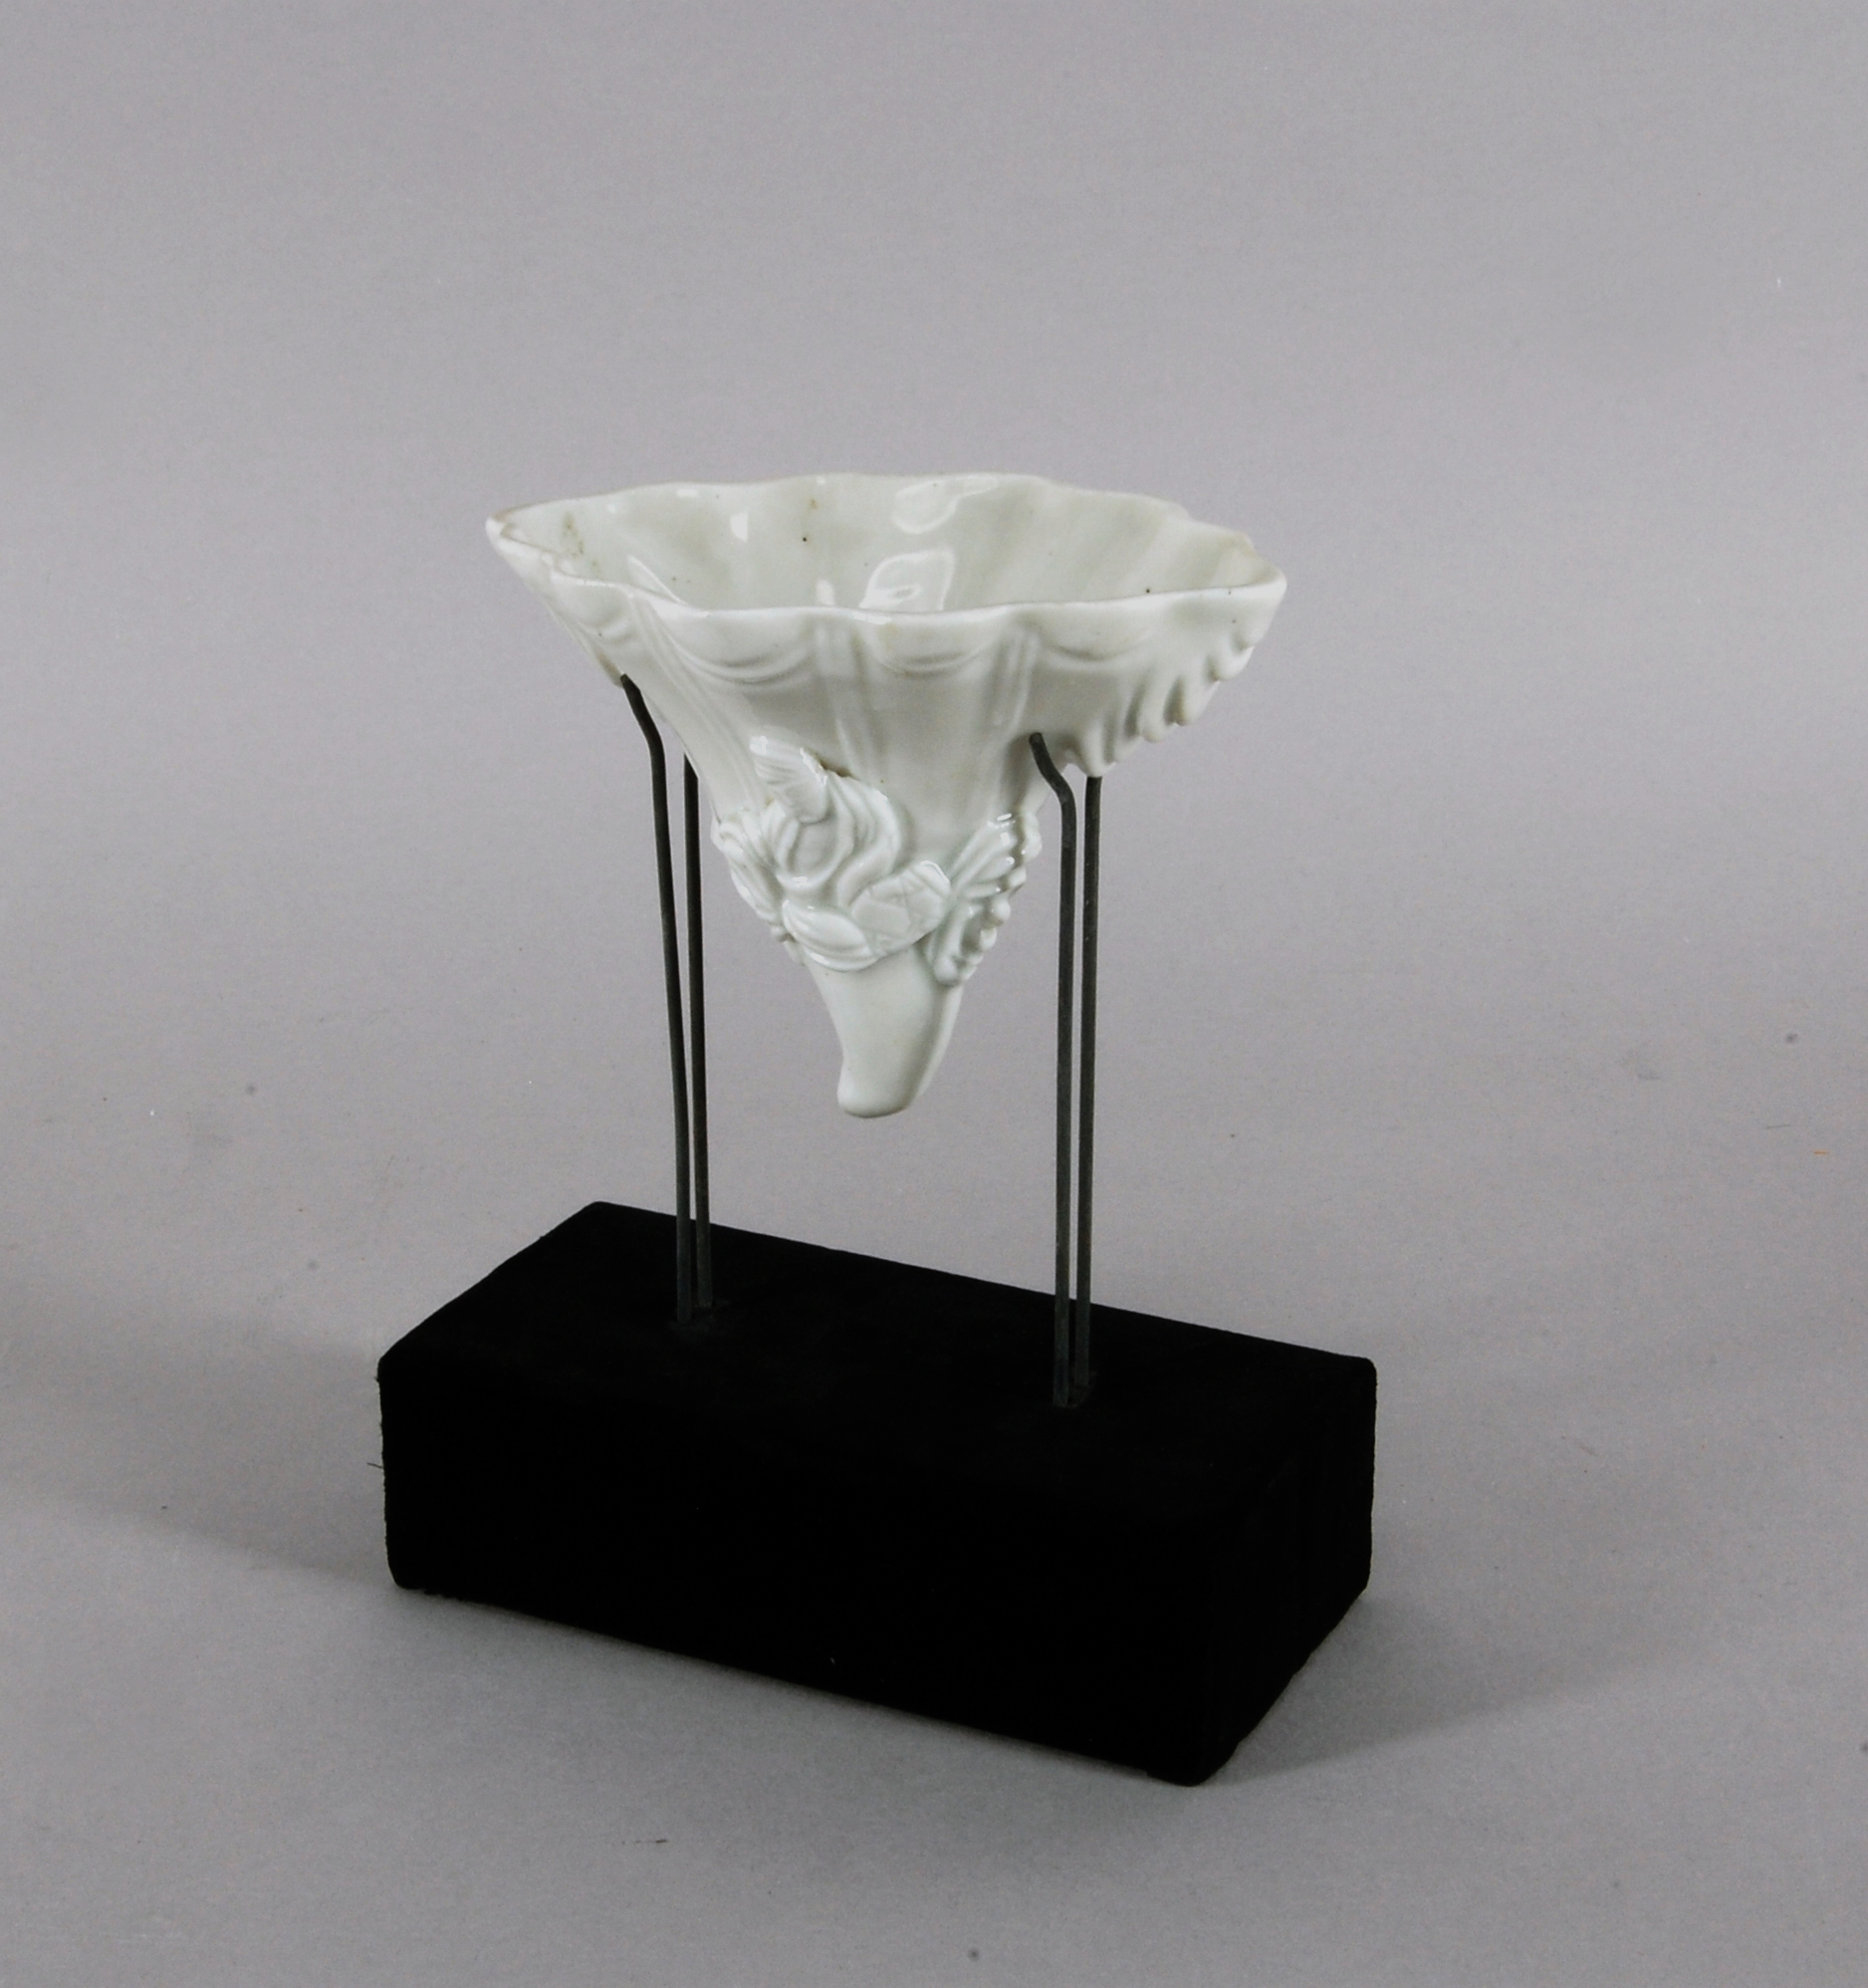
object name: cup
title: Cup in Shape of Rhinoceros Horn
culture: chinese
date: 1701-1800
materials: porcelain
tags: human figures,mythical creatures